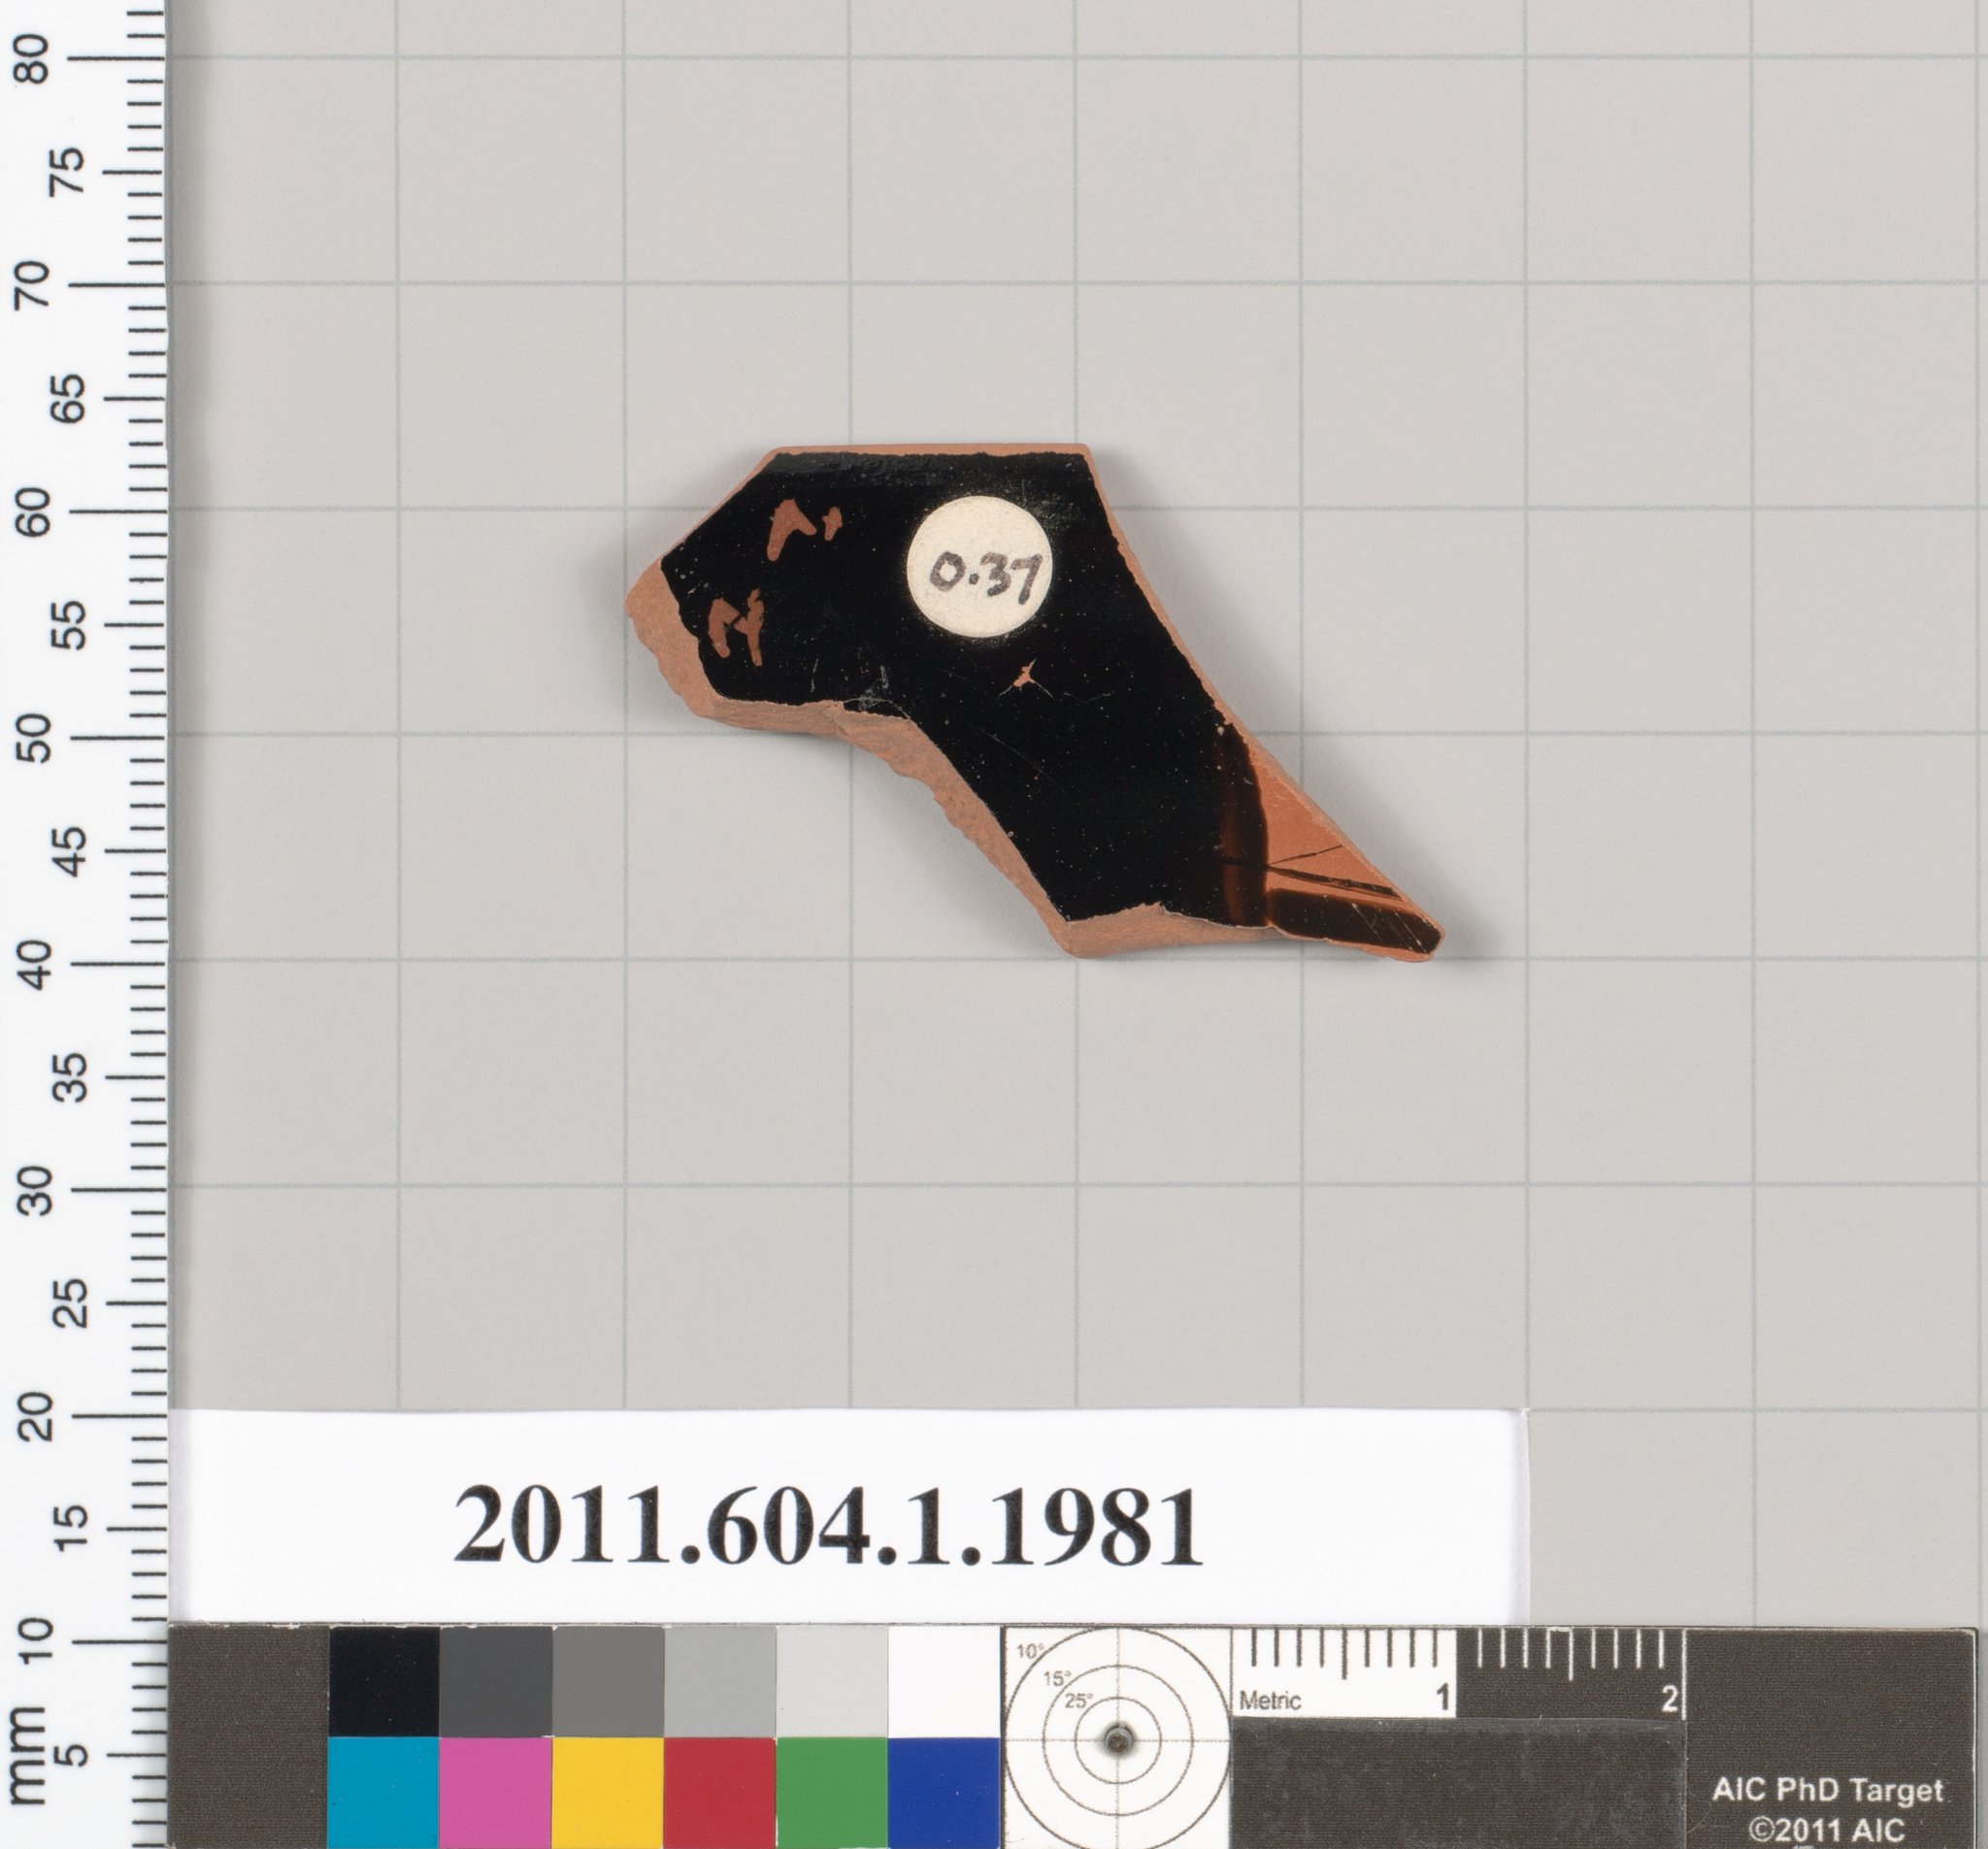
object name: kylix fragment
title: Terracotta rim fragment of a kylix (drinking cup)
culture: greek, attic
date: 500-401 BCE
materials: terracotta